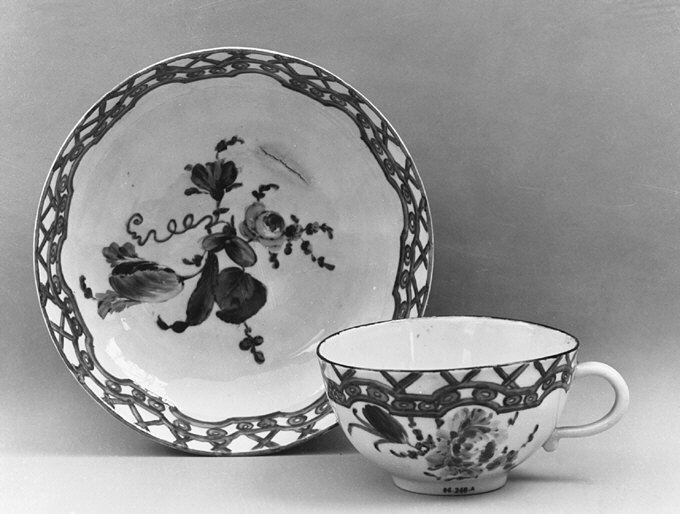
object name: cup and saucer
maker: kloster-veilsdorf porcelain manufactory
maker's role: manufactory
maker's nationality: german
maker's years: 1760-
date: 1770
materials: hard paste porcelain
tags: flowers